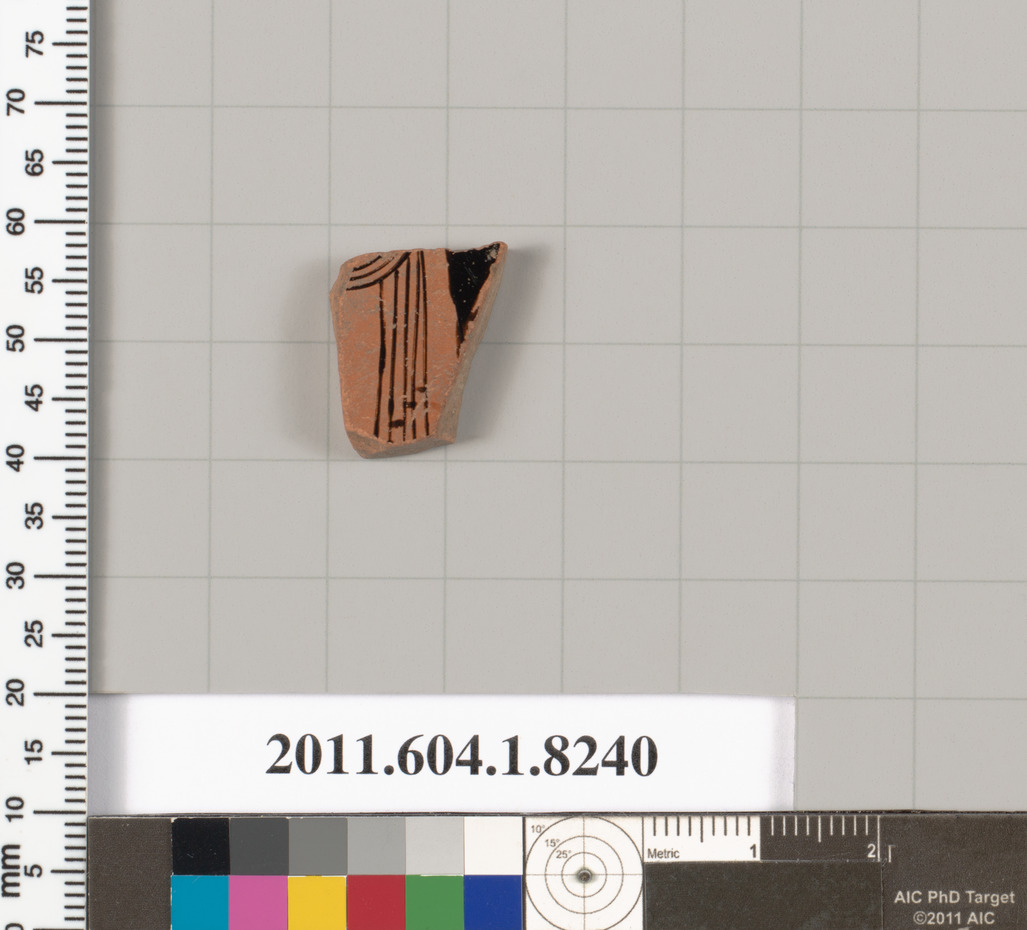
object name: kylix fragment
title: Terracotta fragment of a kylix (drinking cup)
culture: greek, attic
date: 520-510 BCE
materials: terracotta